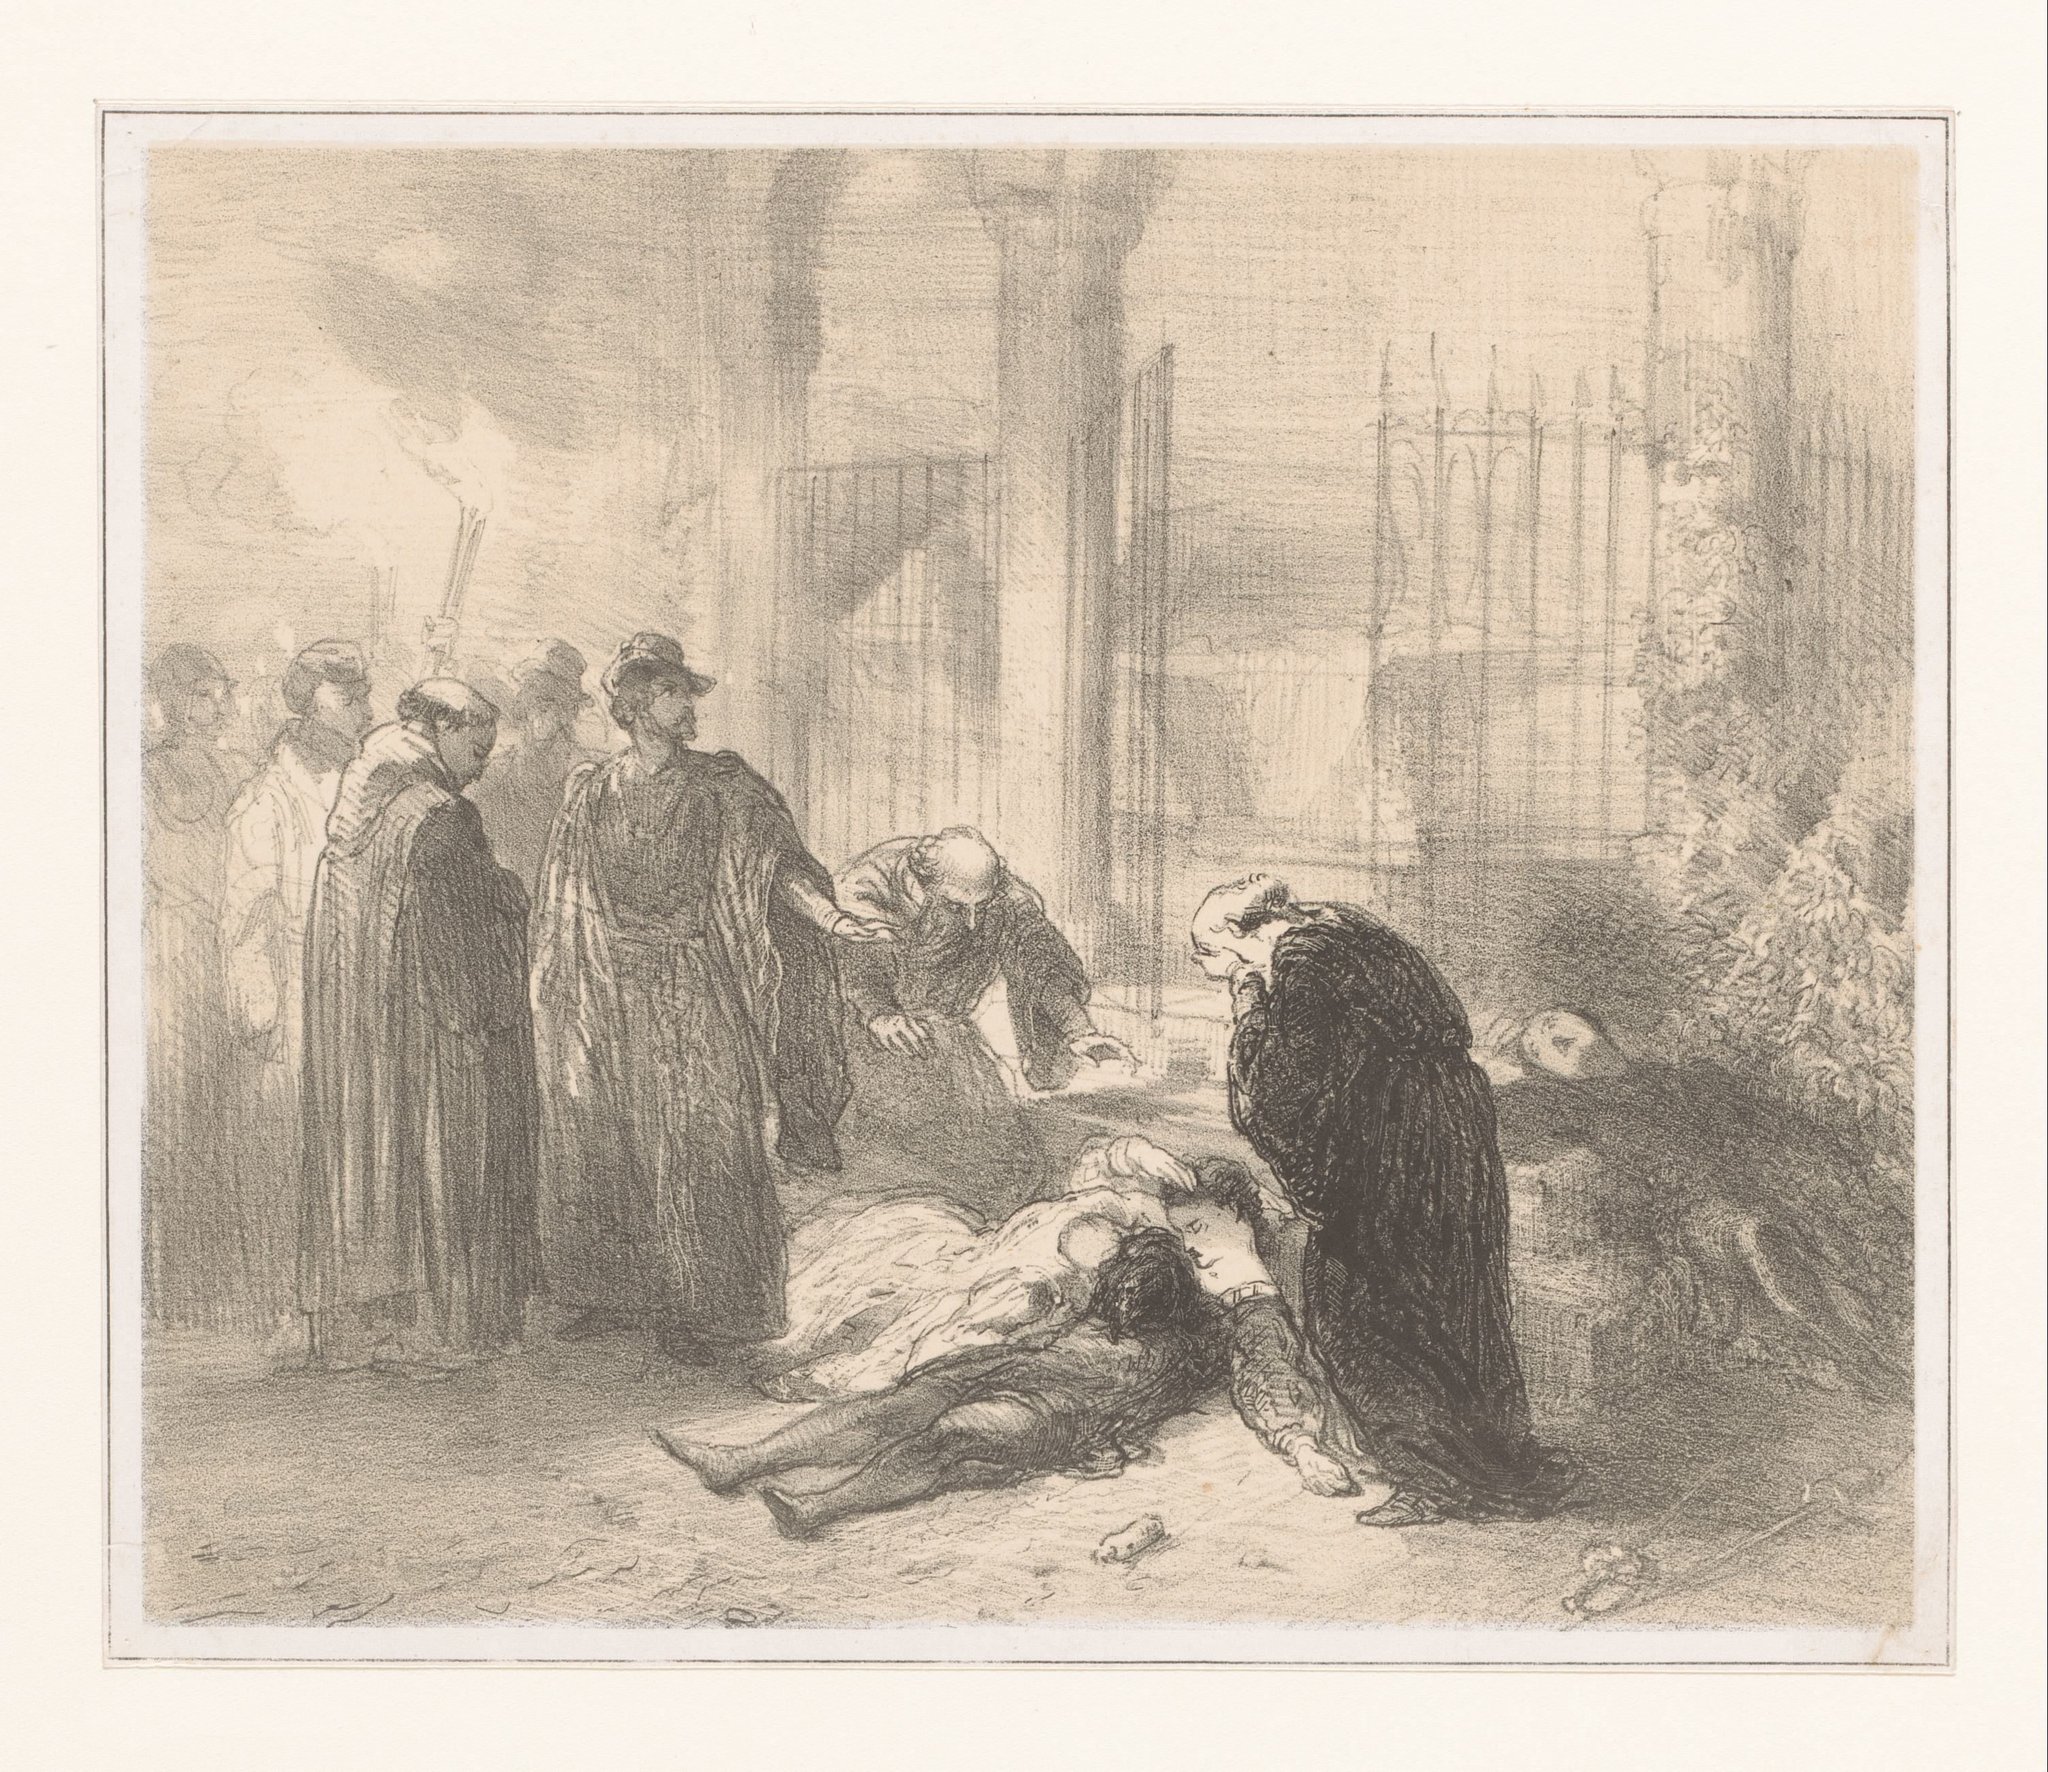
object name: book illustration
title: Lichamen van Romeo en Julia te midden van rouwende figuren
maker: charles rochussen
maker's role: draughtsman, painter, print maker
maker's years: 1814-1894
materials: paper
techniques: tone lithography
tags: romeo, juliet, mourning the dead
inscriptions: collector's mark: Lugt 2760, collector's mark: Lugt 2228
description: Bij de lichamen van Romeo en Julia staan de franciscaner Lorenzo, de vorst van Verona en de graven Capulet en Montague. Zij rouwen om hun dochter en zoon. In de achtergrond staan mannen met fakkels. Rechts ligt het lichaam van de door Romeo vermoorde Paris.